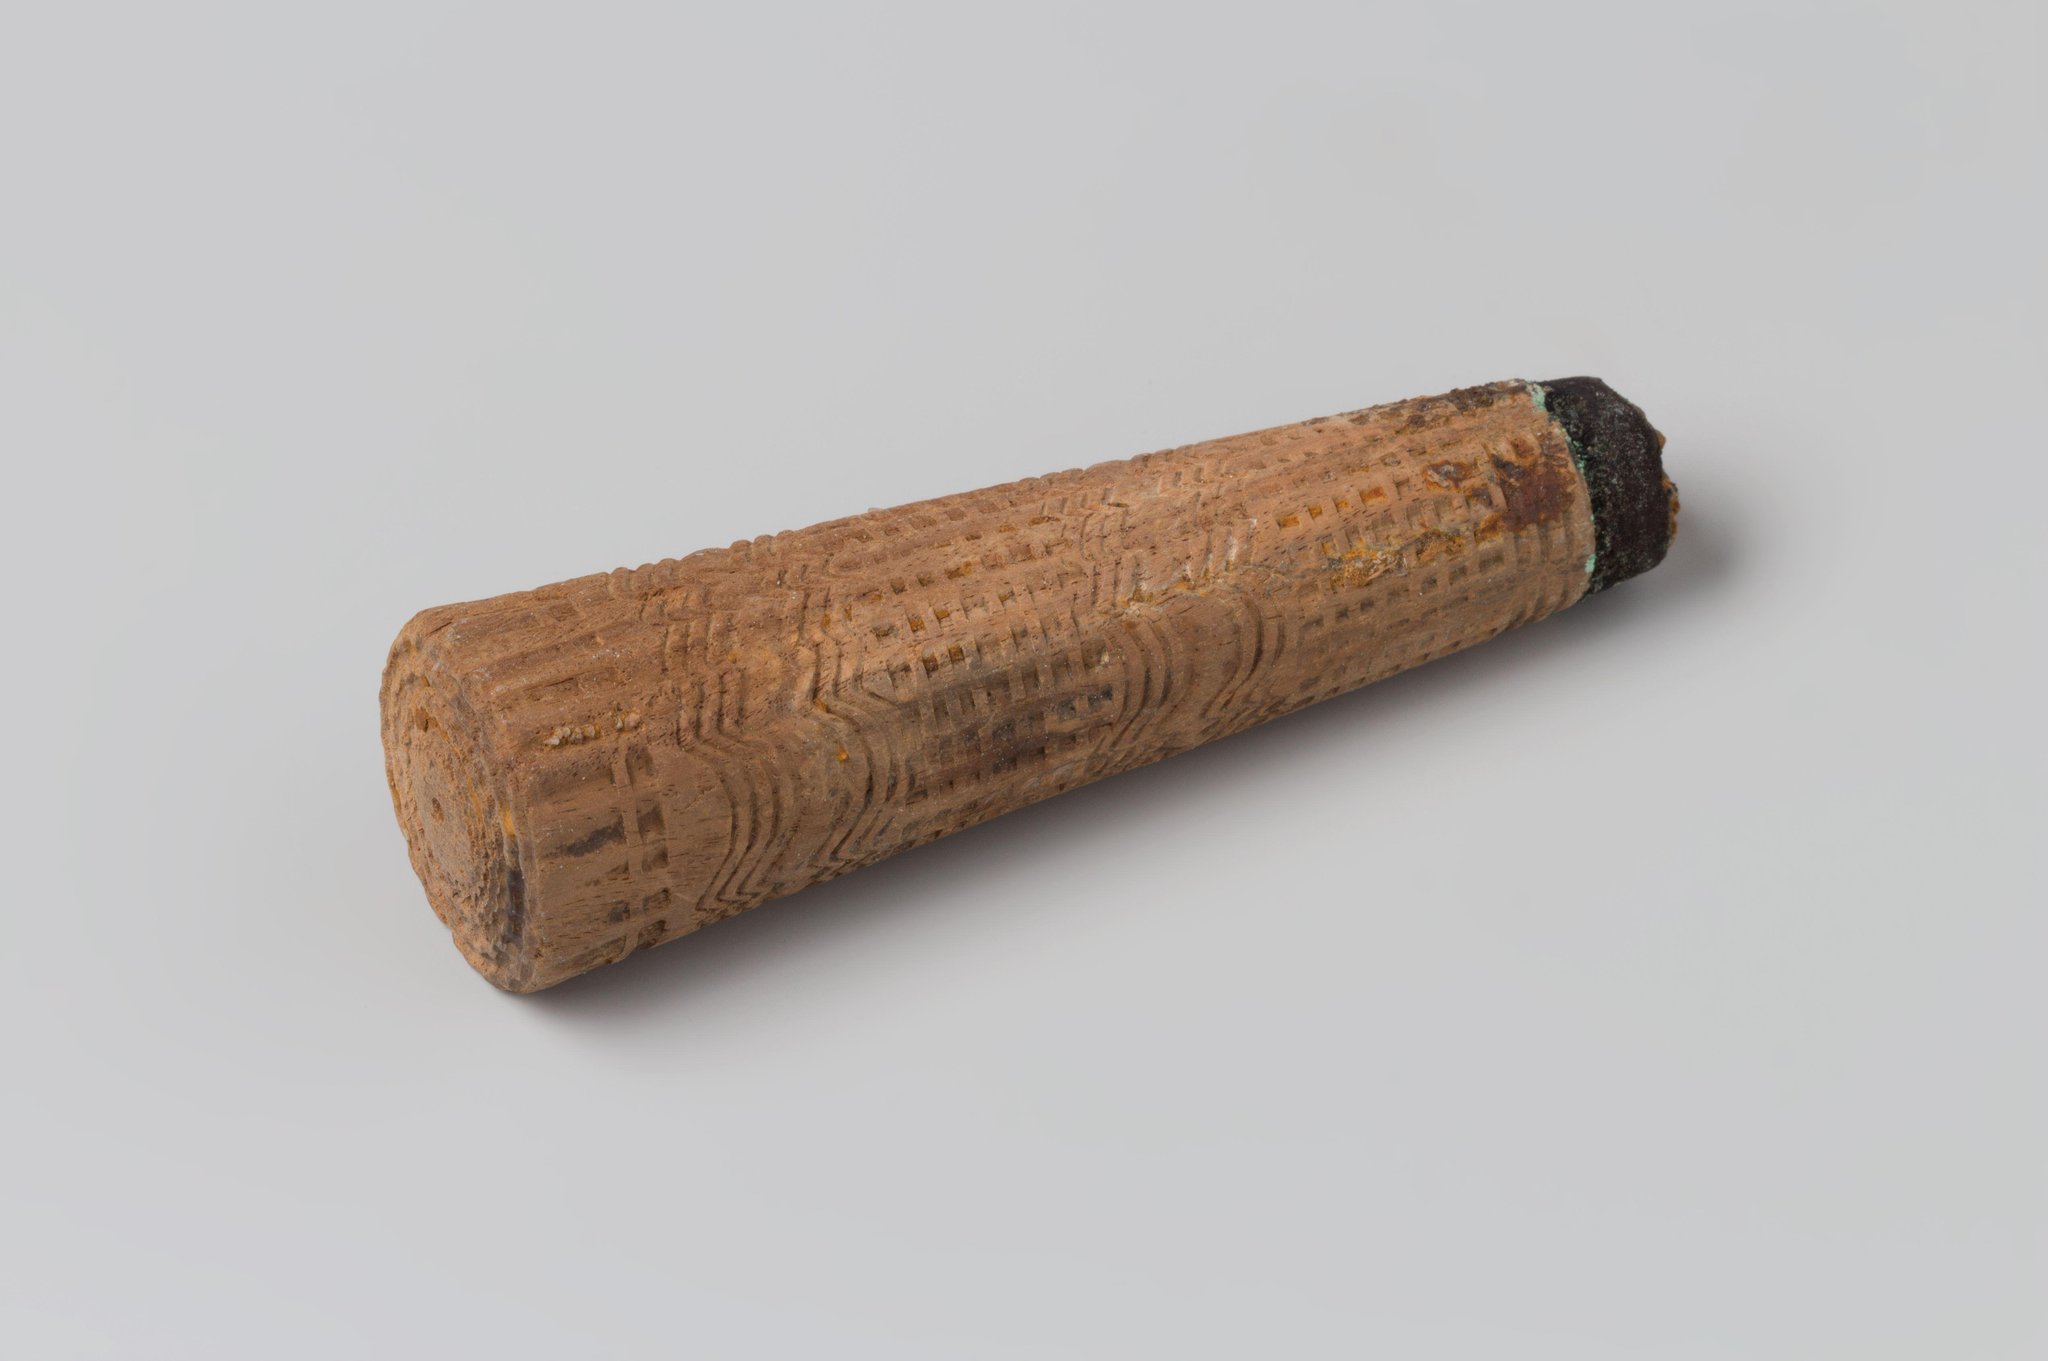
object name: knife handle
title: Messenheft uit het wrak van de Oost-Indiëvaarder Hollandia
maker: Anonymous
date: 1700-1743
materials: copper, wood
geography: netherlands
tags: verenigde oostindische compagnie, hollandia (schip), annet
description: Knife, handle, cylindrical: tapering; id. NG 1979-403H, ferrules, id. NG 1980-27H426.